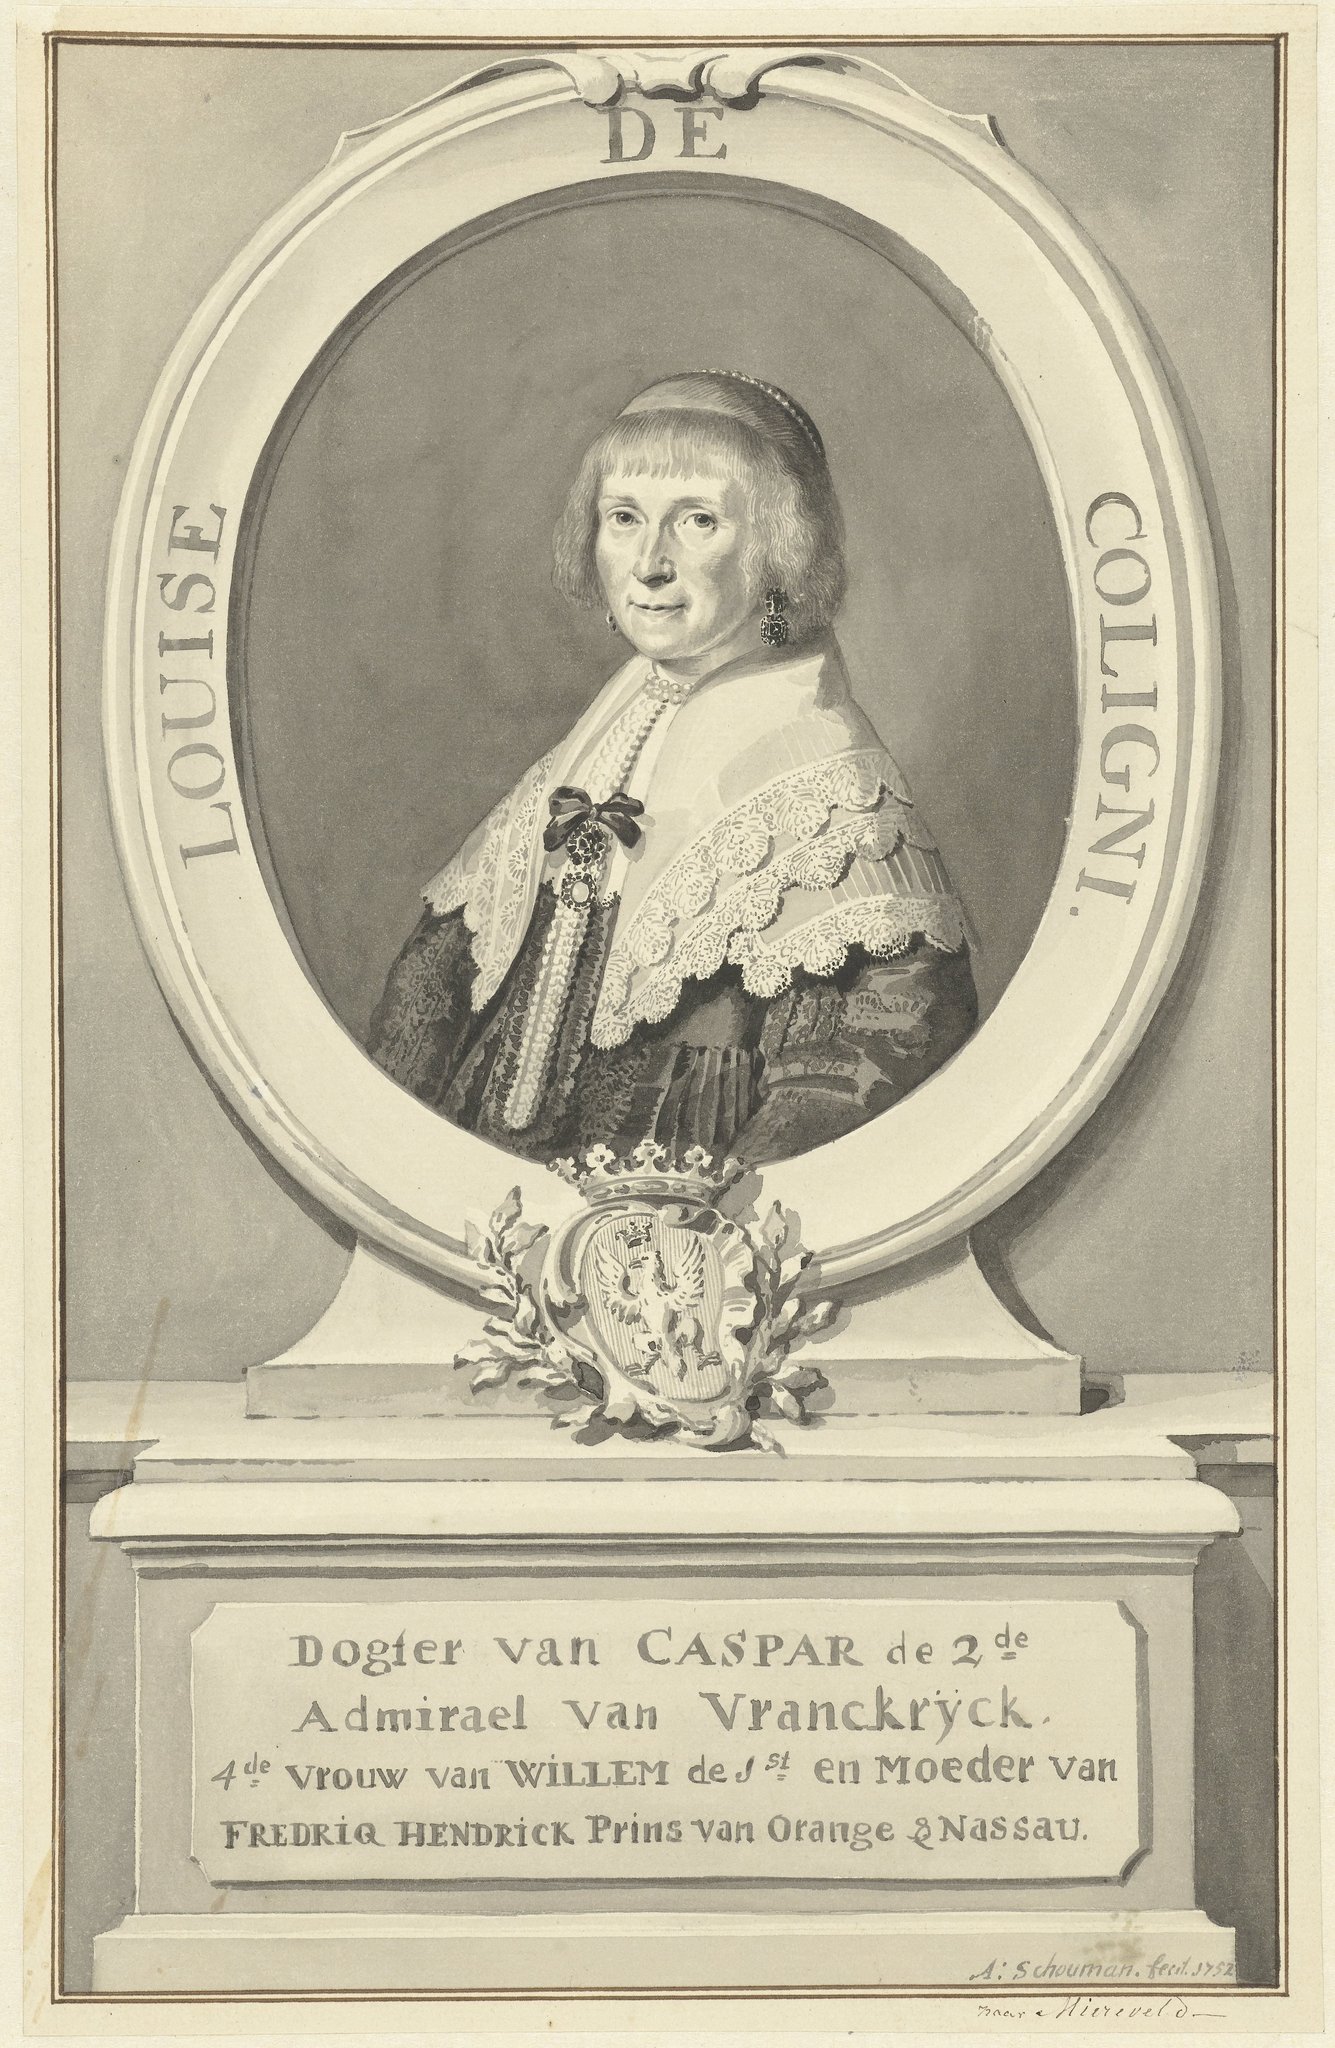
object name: drawing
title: Portret van Louise de Coligny, in ovaal cartouche, naar links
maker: aert schouman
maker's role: draughtsman, painter, print maker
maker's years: 1710-1792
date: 1752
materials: ink, paper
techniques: brush, pen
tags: louise de coligny, historical persons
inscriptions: annotation: ‘naar Miereveld’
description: Portret van Louise de Coligny, in ovaal cartouche, met onderschrift; naar links. Boven: LOUISE DE COLIGNI. Onder: Dogter van CASPAR de 2de / Admirael van Vranckrijck. /4de Vrouw van WILLEM de 1st en moeder van FREDRIQ HENDRICK Prins van Orange & Nassau.